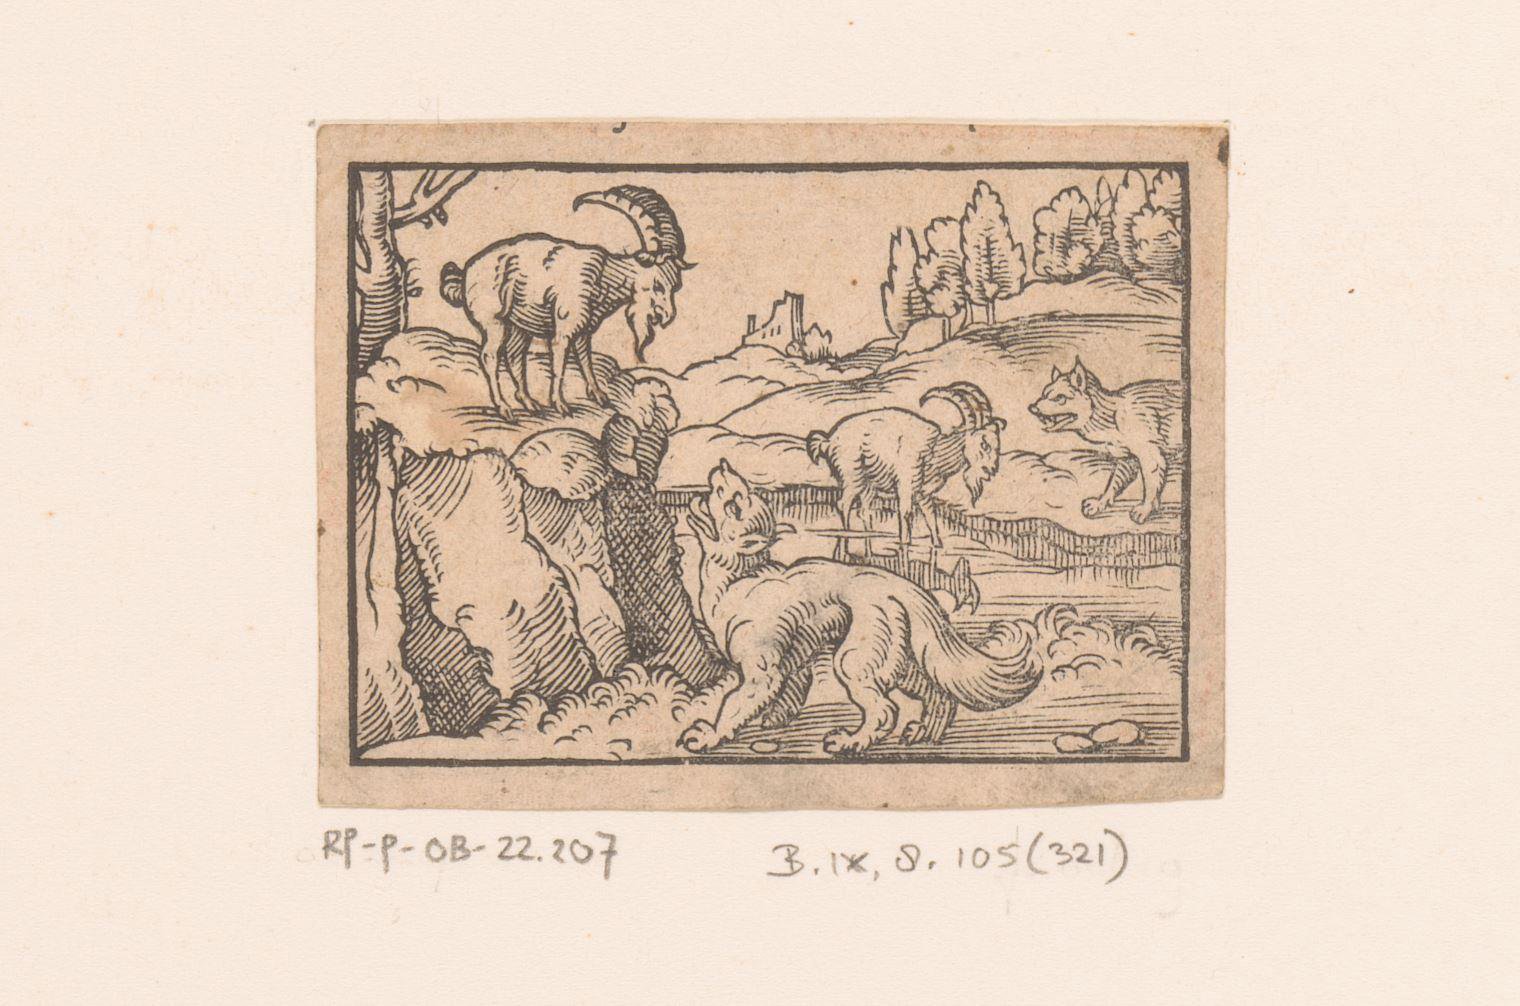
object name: print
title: Fabel van de geit en de leeuw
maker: virgilius solis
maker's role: draughtsman, print maker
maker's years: 1514-1562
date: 1566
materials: paper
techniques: woodcut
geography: nuremberg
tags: goat, beasts of prey, predatory animals: lion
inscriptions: number: ‘184’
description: Illustratie bij de Fabels van Aesopus, onder meer gebruikt voor de publicatie: Posthius, Johann. Aesopi Phrygis Fabulae. Frankfurt am Main: Sigmund Feyerabend, Georg Rab en erven Weigand Han, 1566.